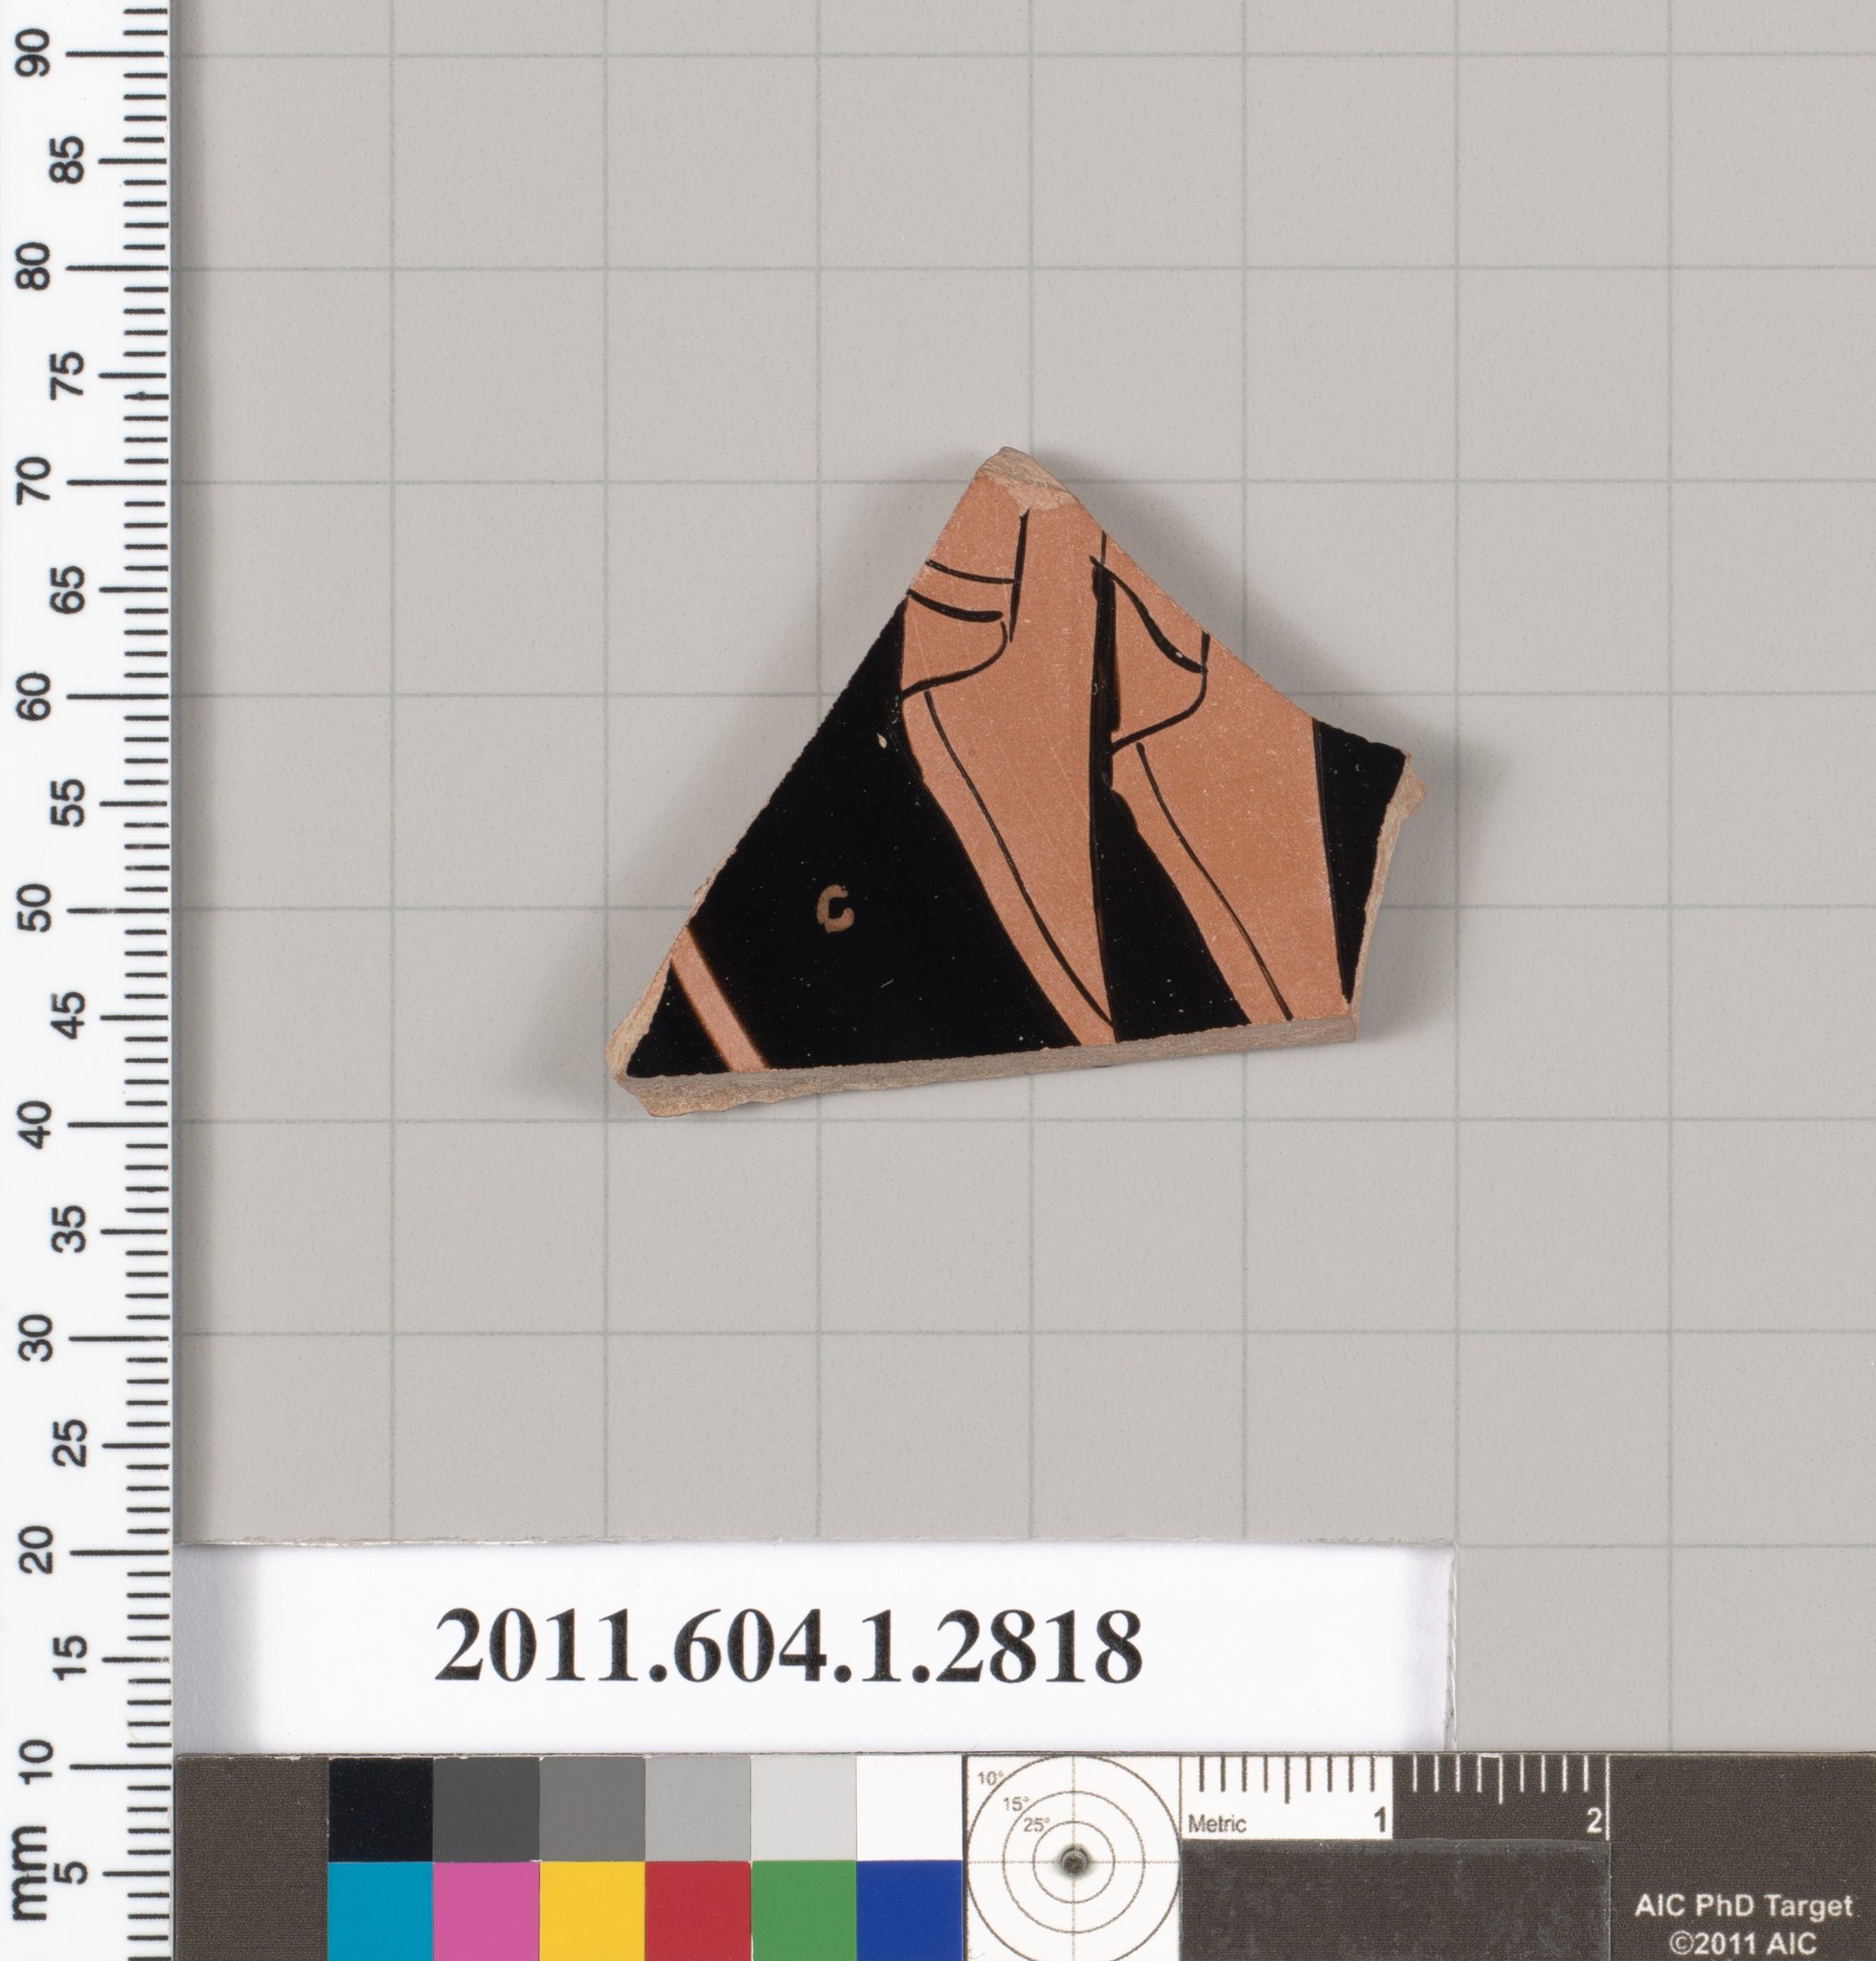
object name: kylix fragment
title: Terracotta fragment of a kylix (drinking cup)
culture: greek, attic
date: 520-500 BCE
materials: terracotta